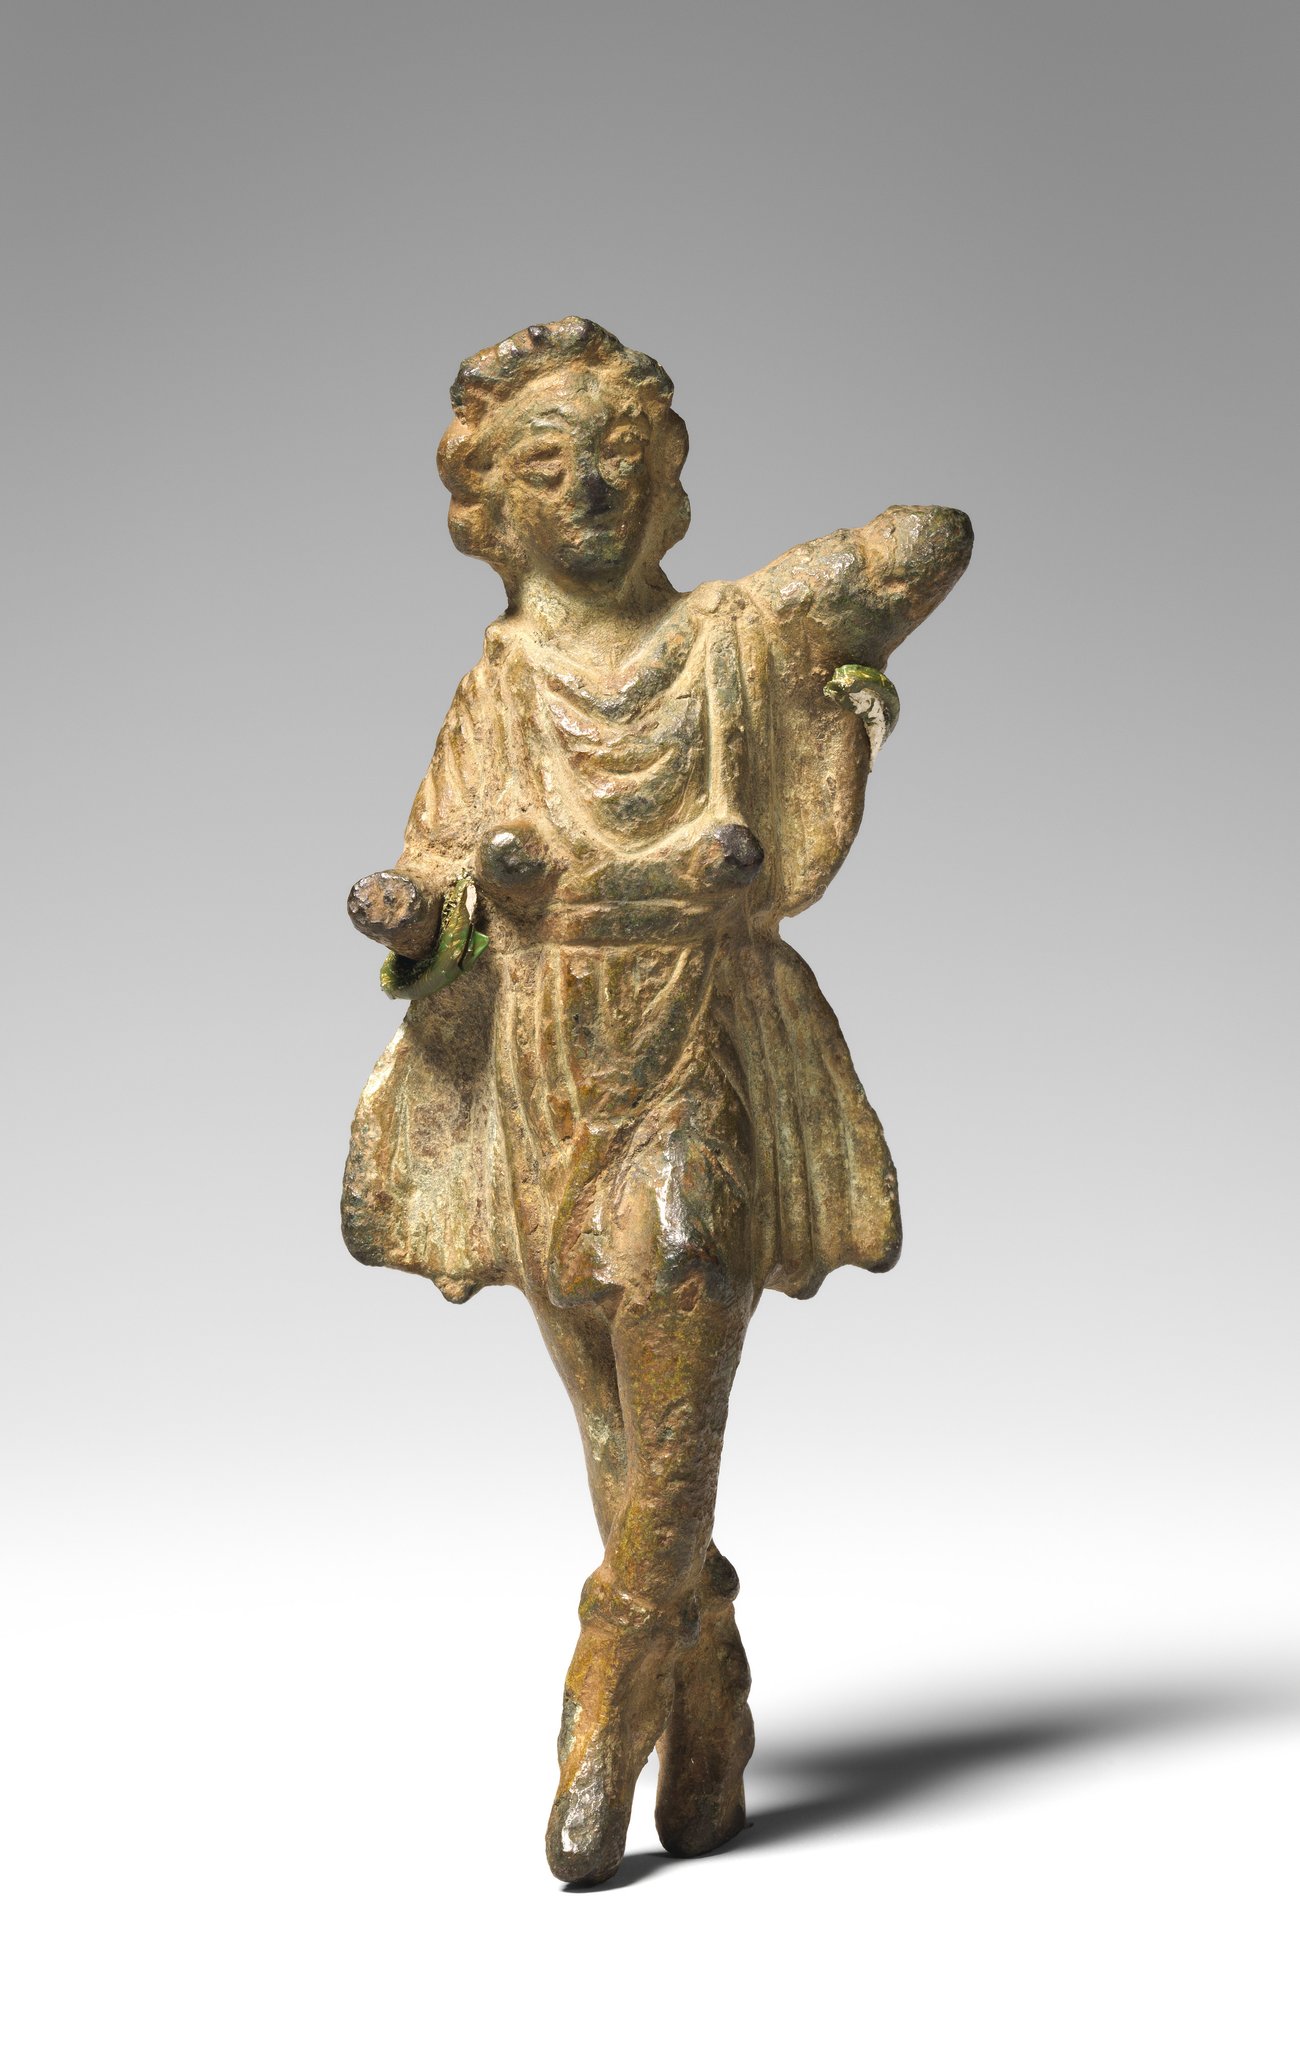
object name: statuette of a lar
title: Bronze statuette of a Lar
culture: roman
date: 1-200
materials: bronze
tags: men